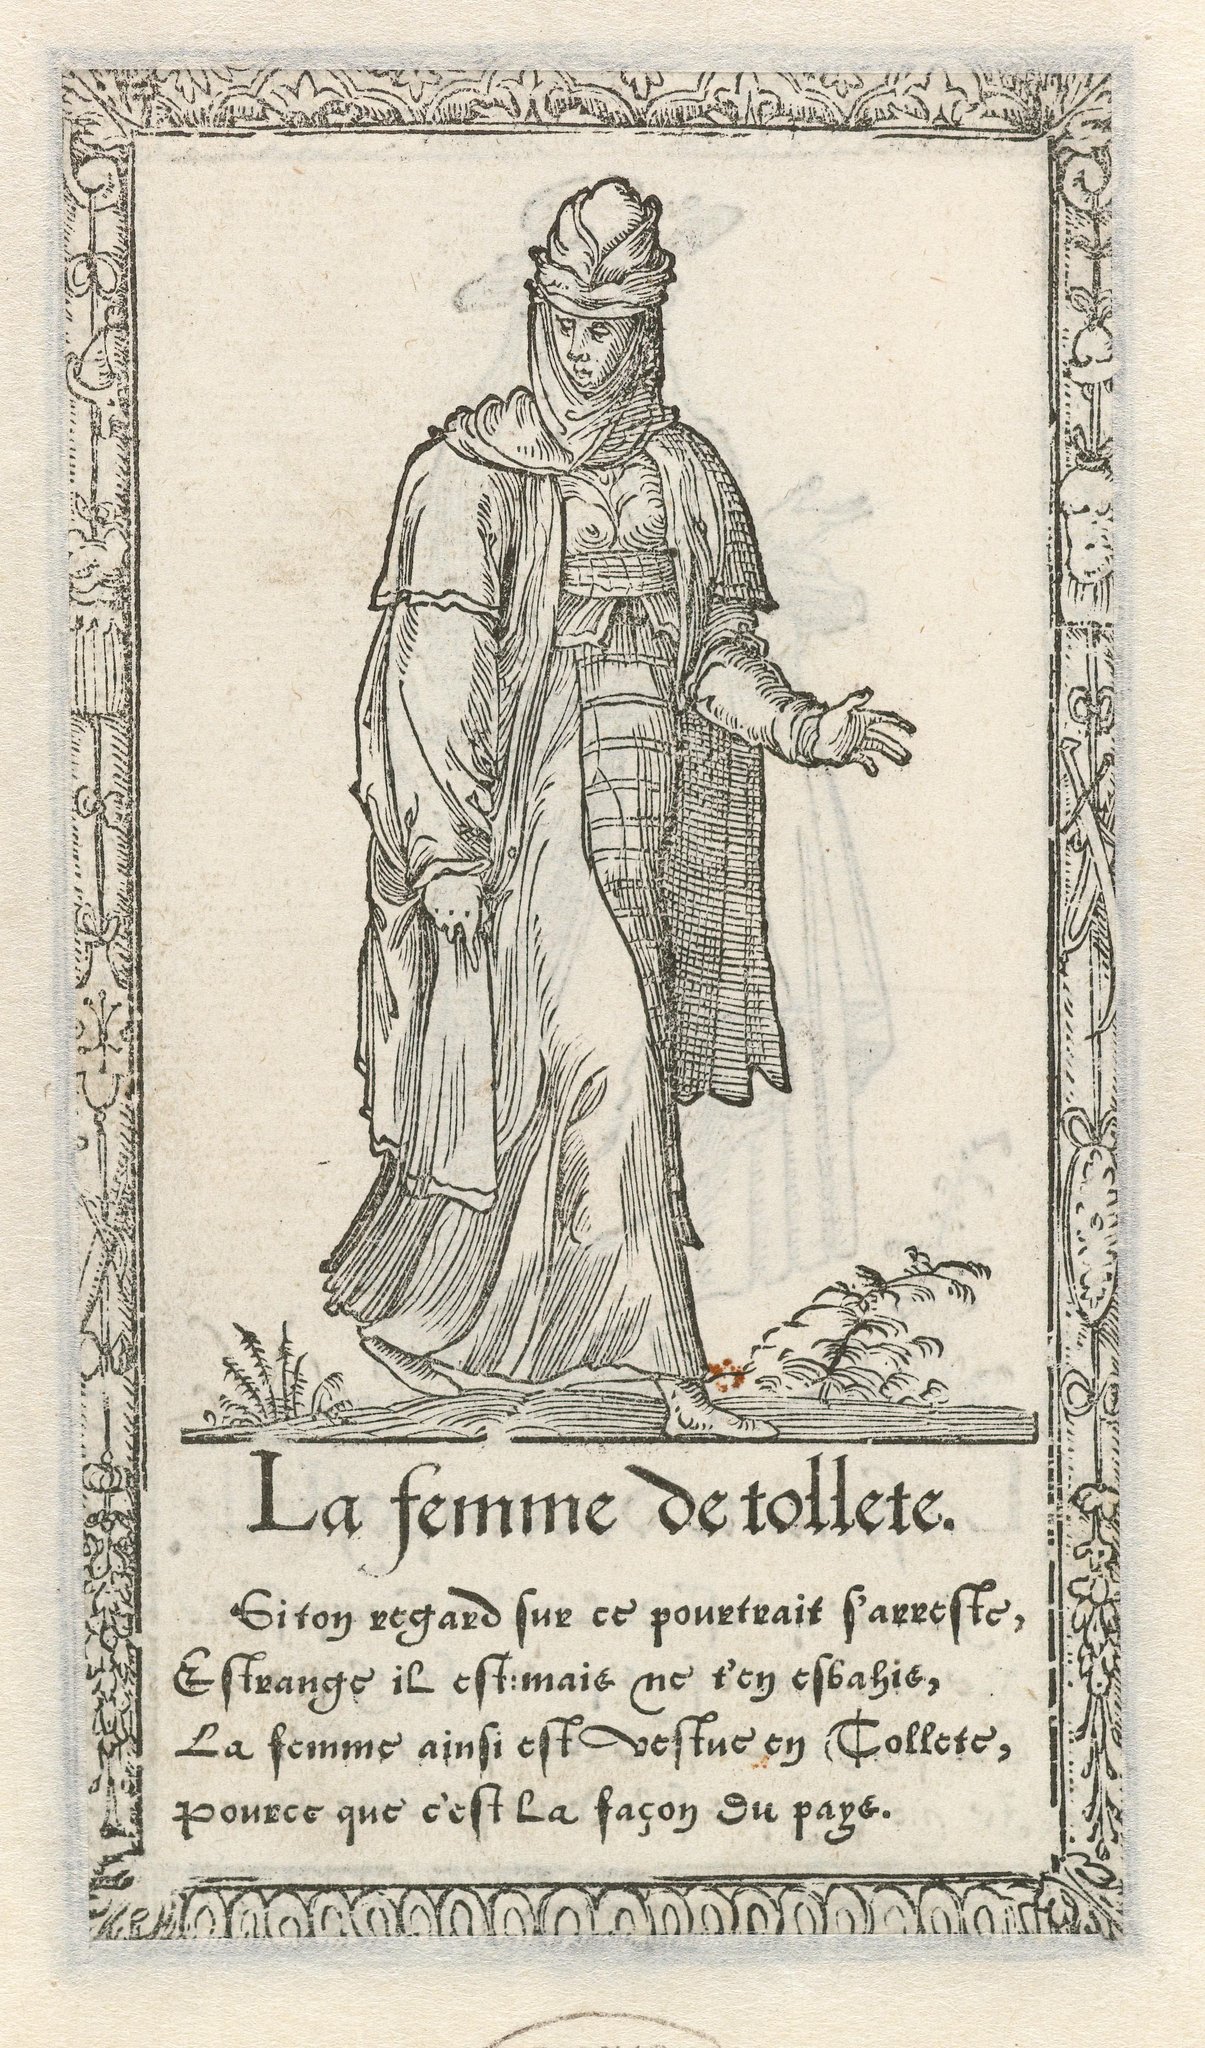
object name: print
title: La femme de tolette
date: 1562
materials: paper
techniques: woodcut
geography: paris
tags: europeans: spaniards (+ costume), fashion plates, folk costume, regional costume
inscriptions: collector's mark: Lugt 2228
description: Dit is prent 80 uit een serie van 121. Binnen deze serie zijn er prenten gemaakt naar voorbeelden van Jean-François de Roberval en Enea Vico, onbekend welke precies.